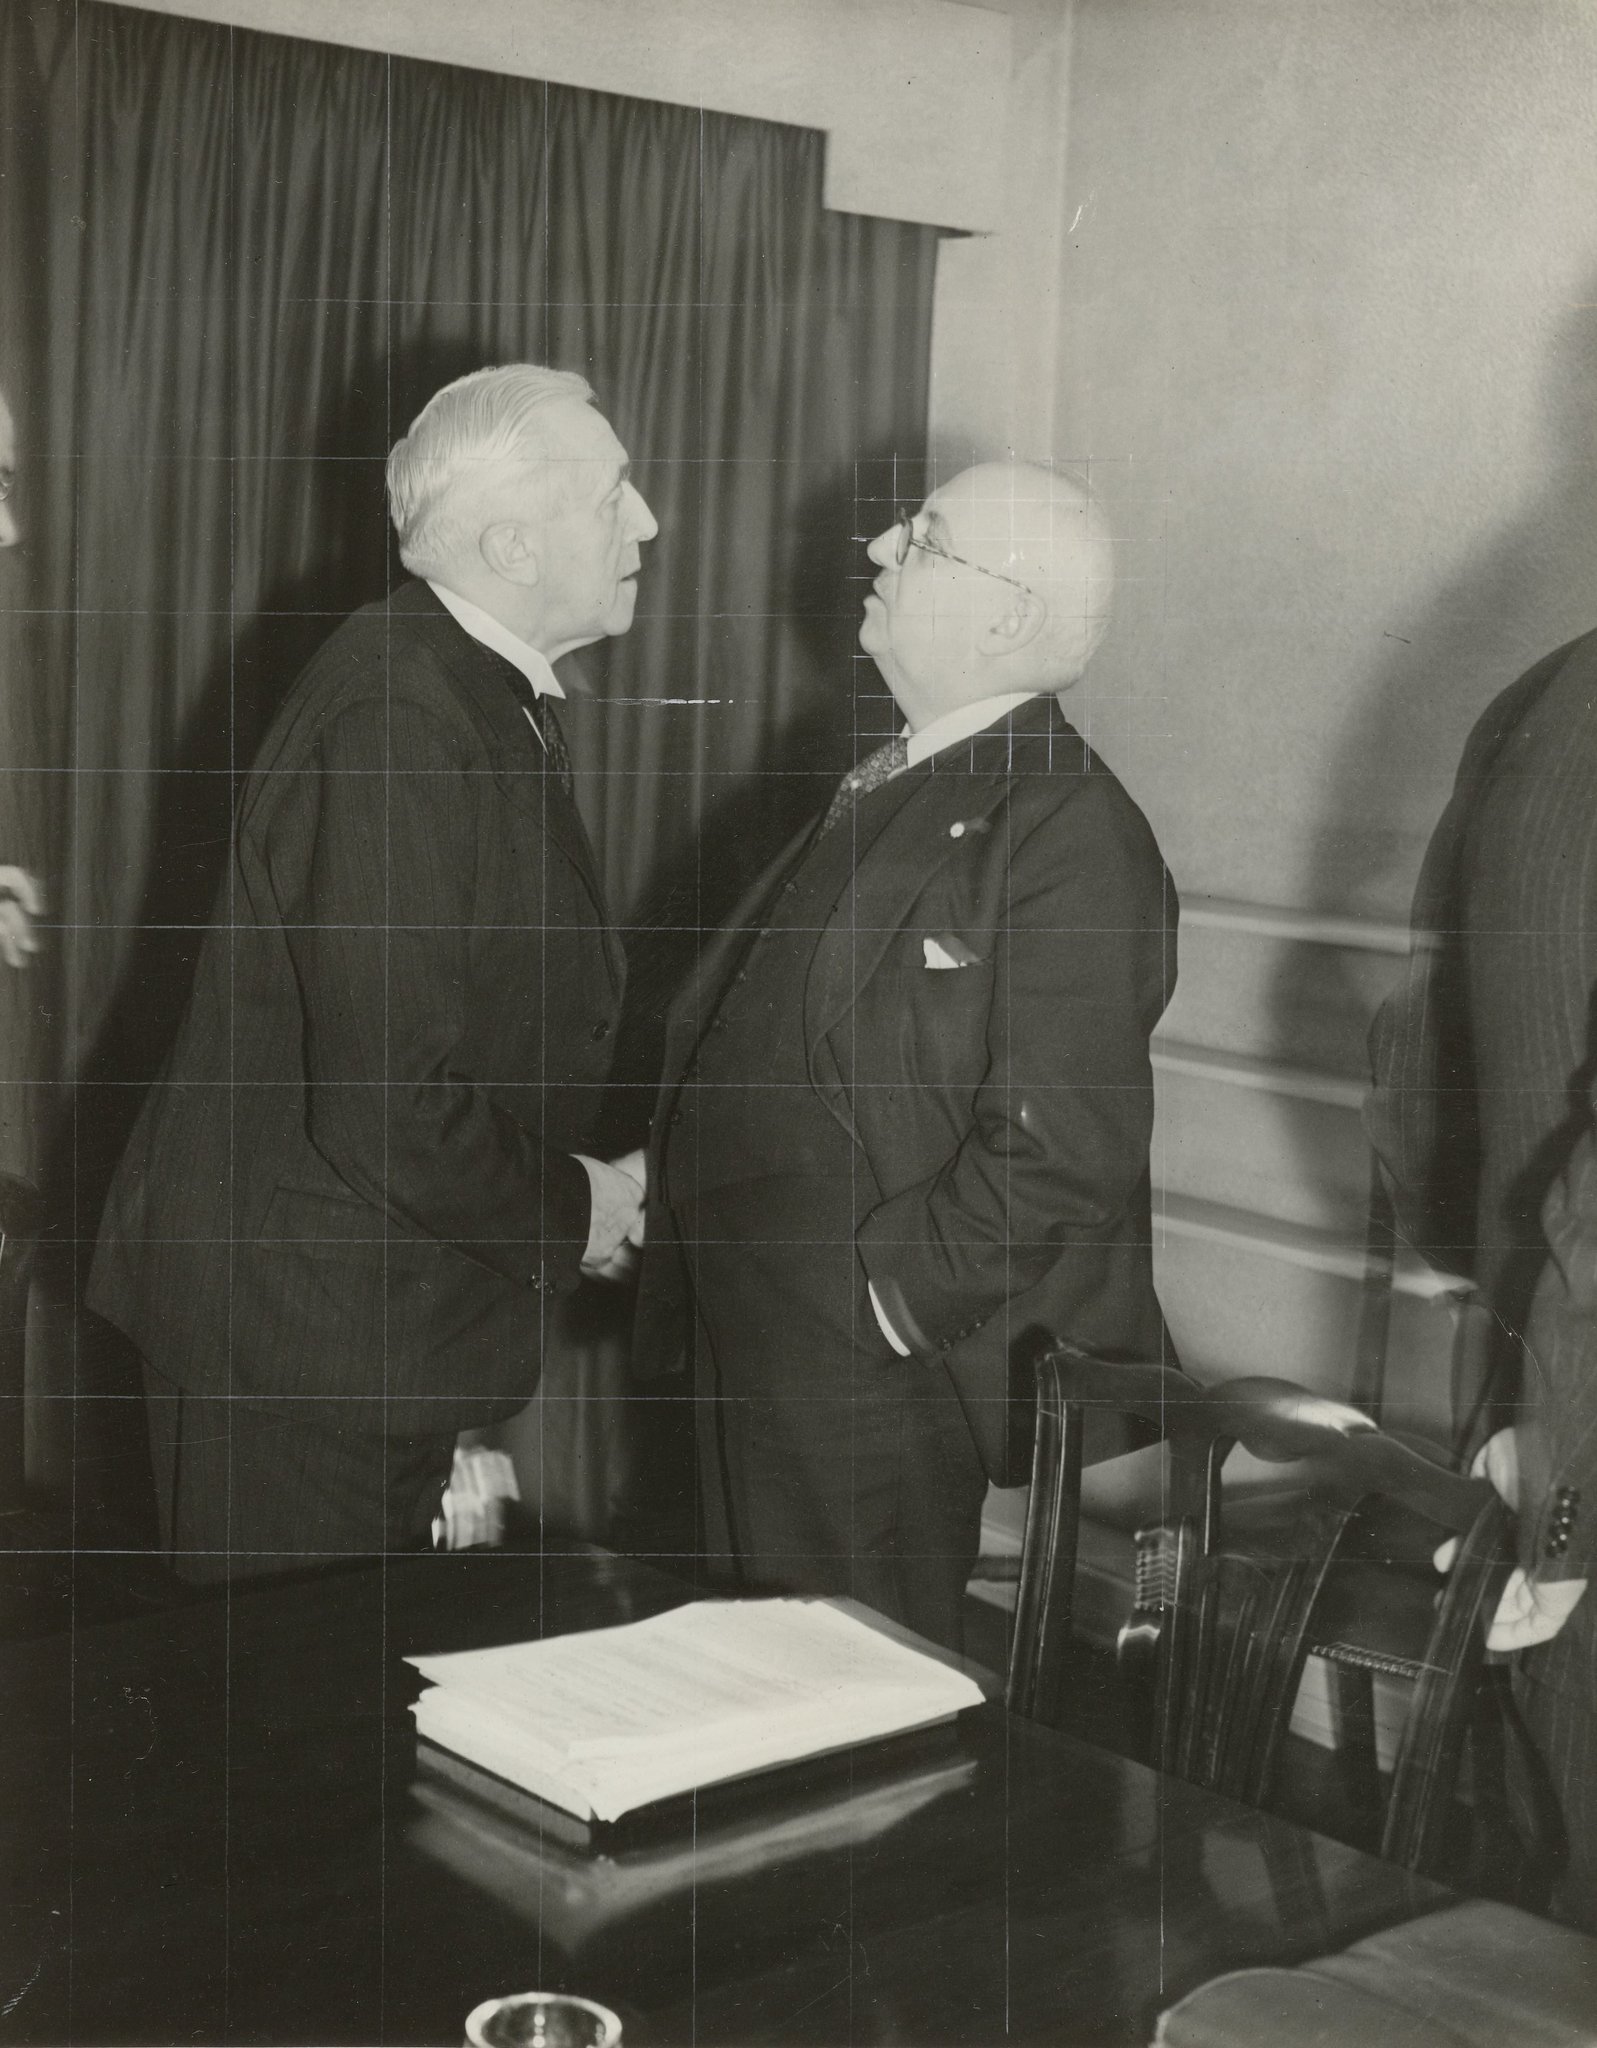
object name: correspondence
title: Minister Bolkestein begroet zijn collega minister O.C.A. van Lidt de Jeude in Stratton House in Londen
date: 1940-1945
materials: photographic support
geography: london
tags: the hague, london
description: Minister van onderwijs Gerrit Bolkestein (1871-1956) begroet zijn collega jonkheer Otto van Lidt de Jeude, minister van oorlog, in Stratton House in Londen. Het raster is aangebracht door kunstenaar Cor Visser. Deze afbeelding van Bolkestein is door Visser gebruikt voor zijn grote groepsportret van het tweede oorlogskabinet Gerbrandy.